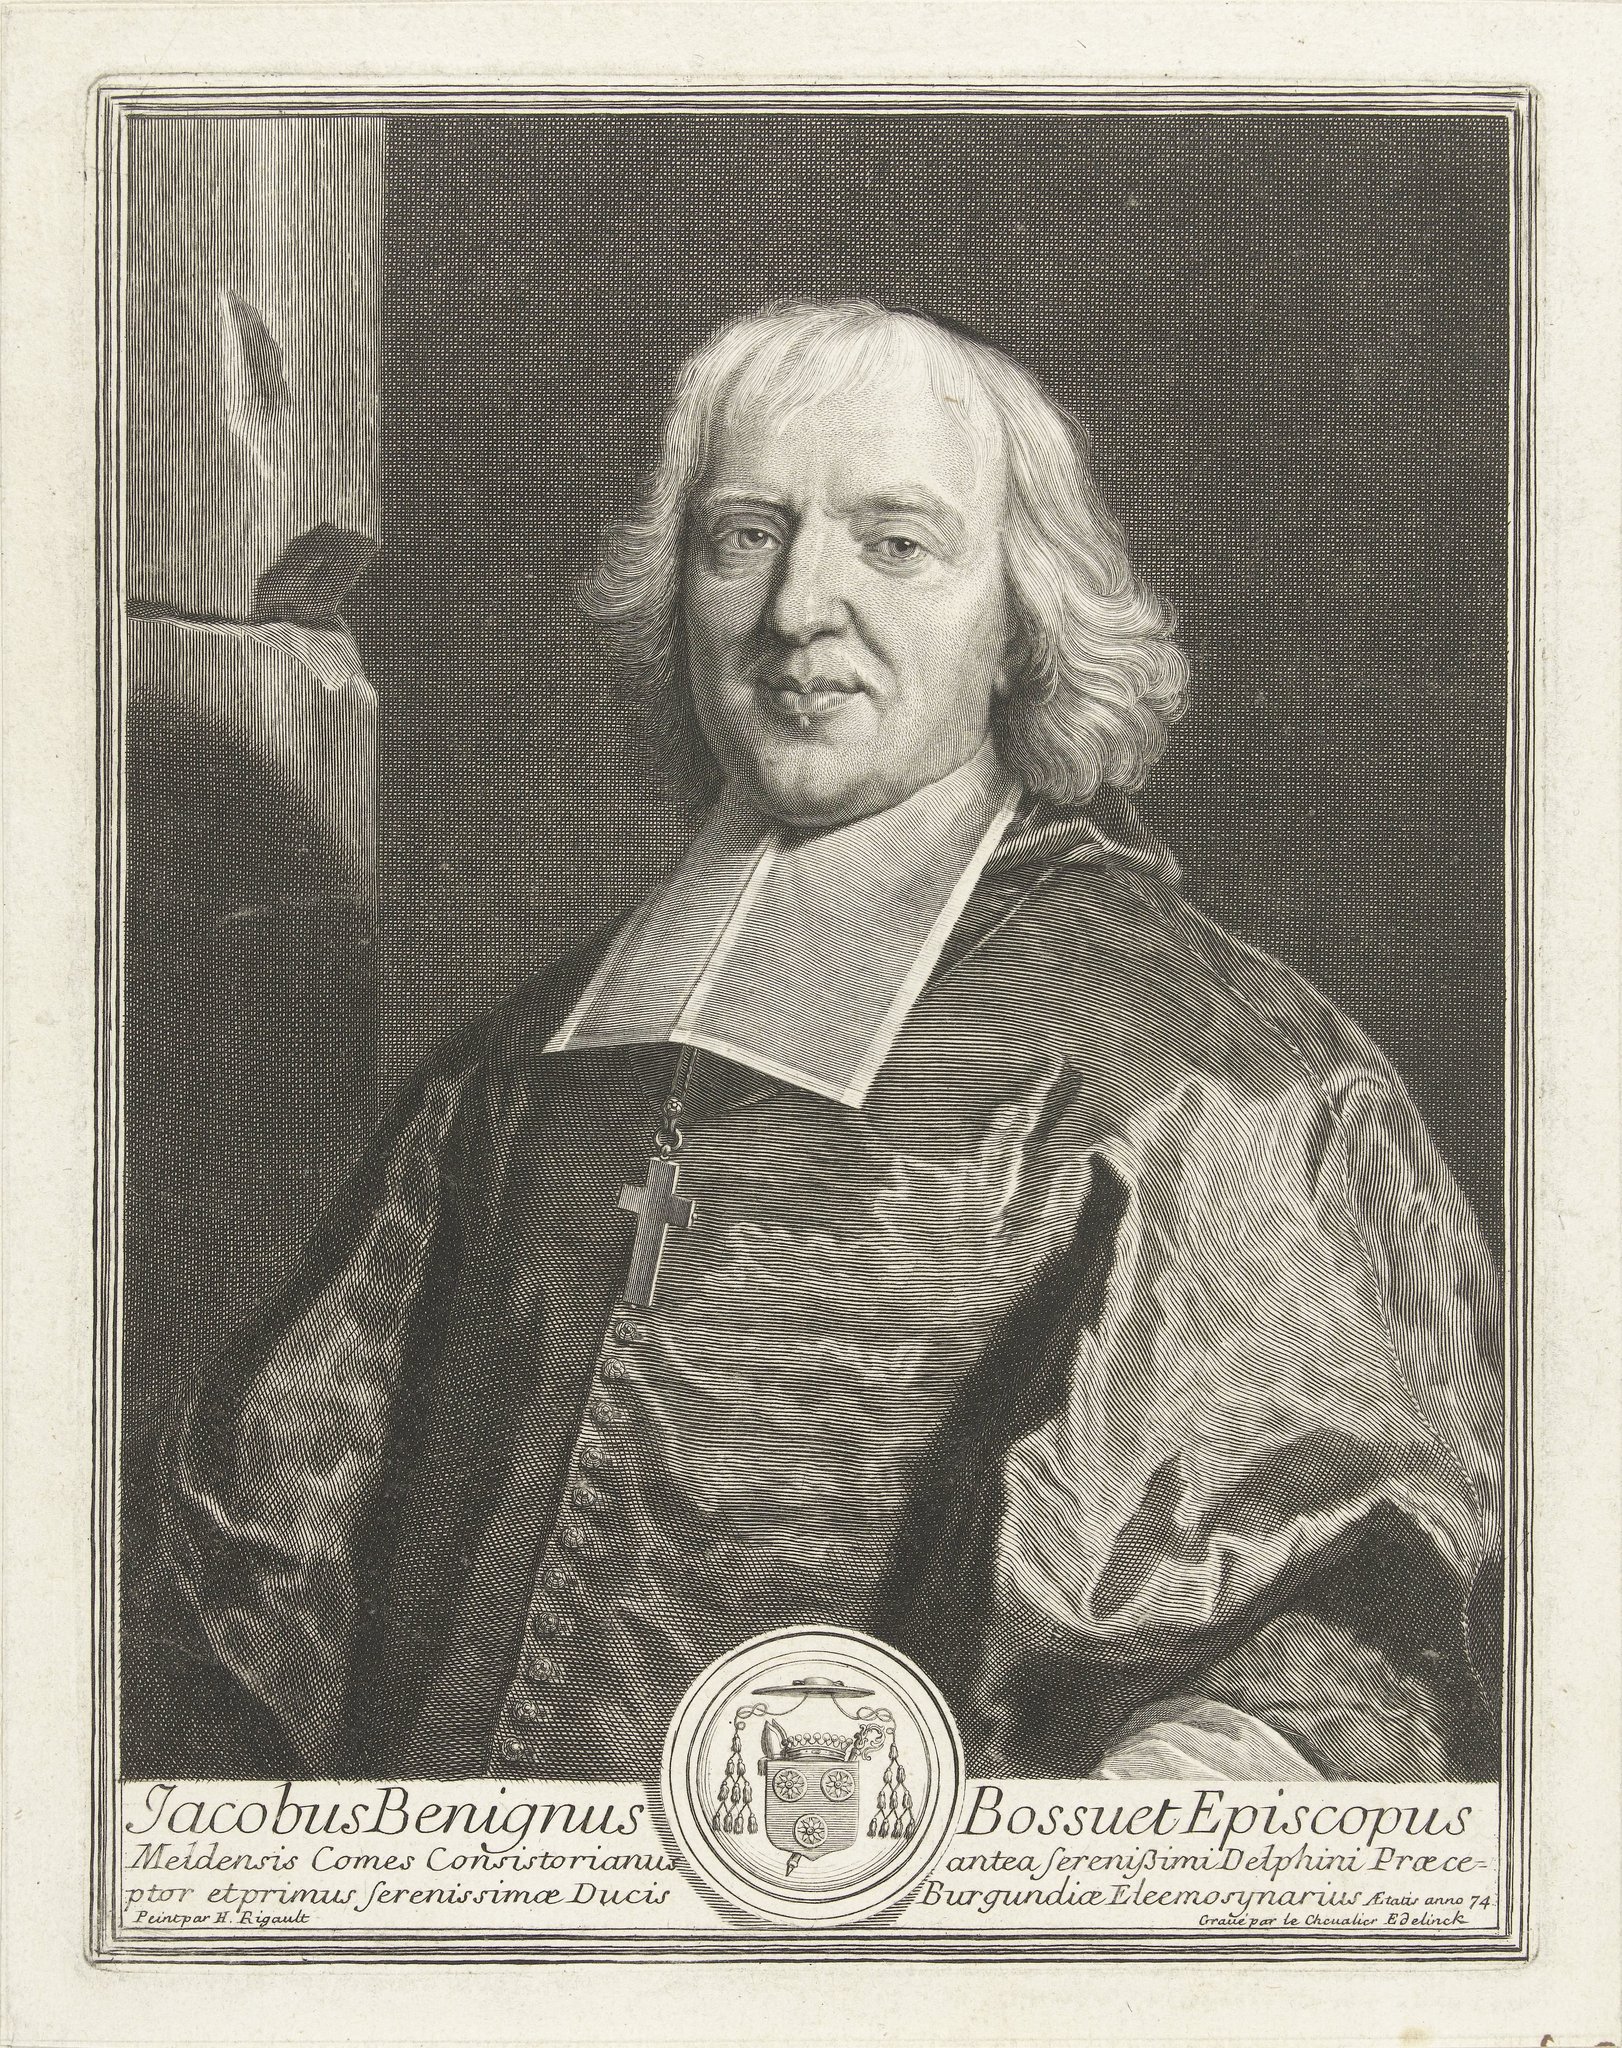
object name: print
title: Portret van Jacques Bénigne Bossuet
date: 1674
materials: paper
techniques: engraving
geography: paris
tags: paris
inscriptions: collector's mark: Lugt 240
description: Portret van de Franse bisschop Jacques Bénigne Bossuet (1627-1704), afgebeeld ten halven lijve, naast een stenen pilaar. Onder het portret drie regels tekst in Latijn en in het midden het wapen van de bisschop.